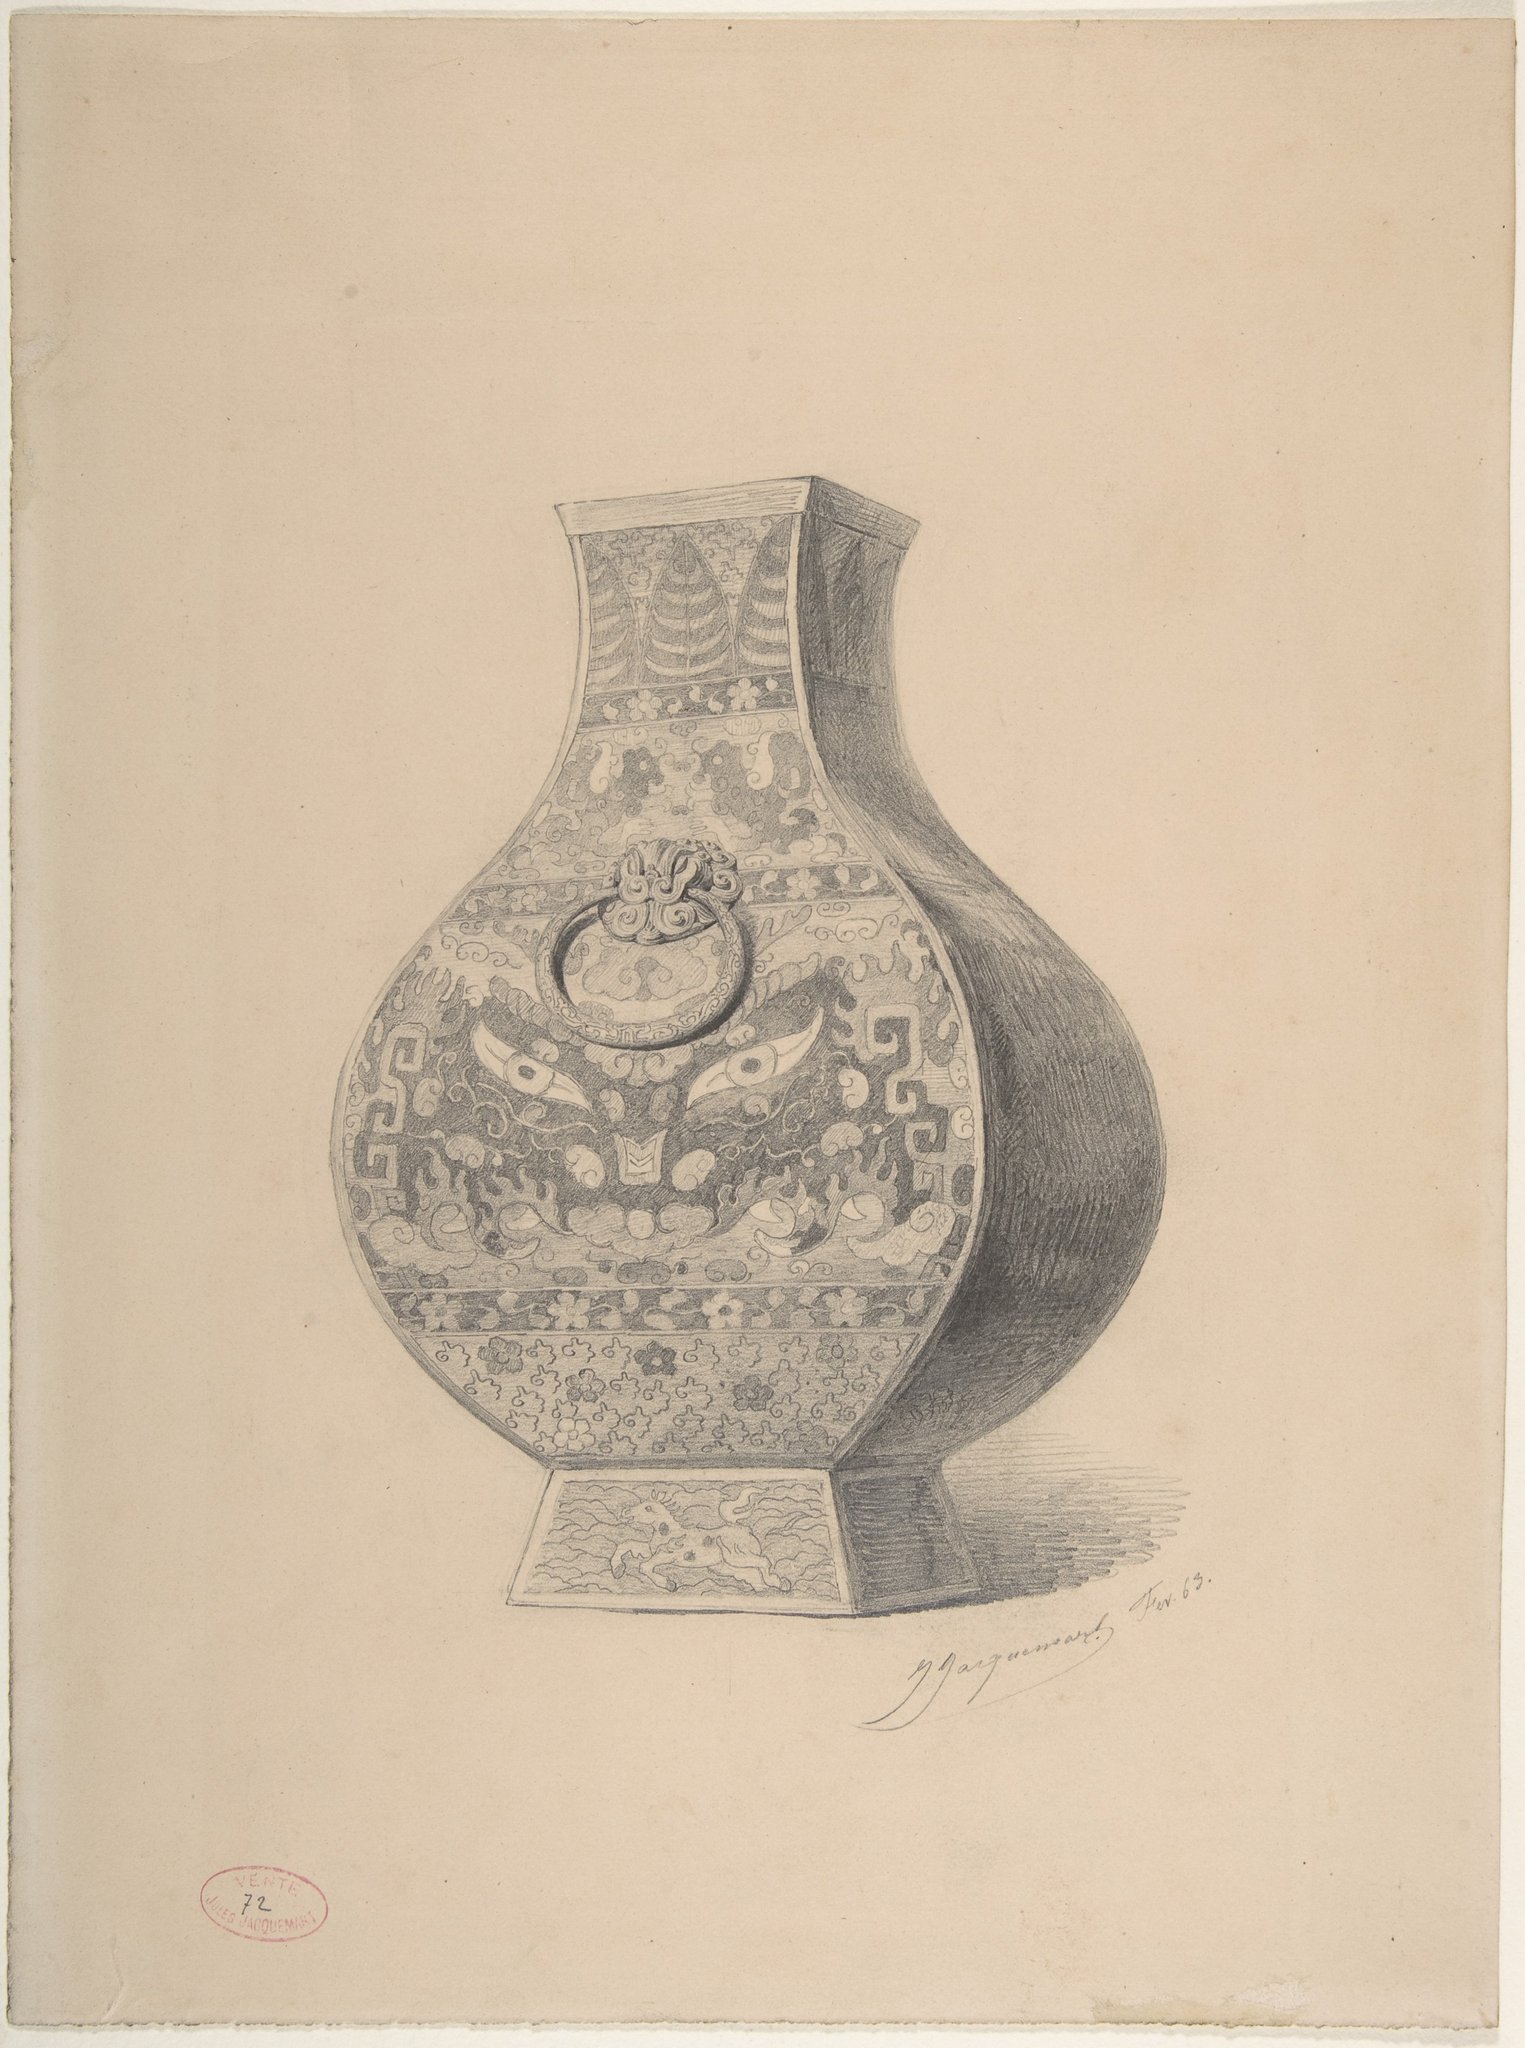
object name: drawing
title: A Chinese Vase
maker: jules-ferdinand jacquemart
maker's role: artist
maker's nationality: french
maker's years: 1837-1880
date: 1834-1866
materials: graphite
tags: eyes,horses,vases